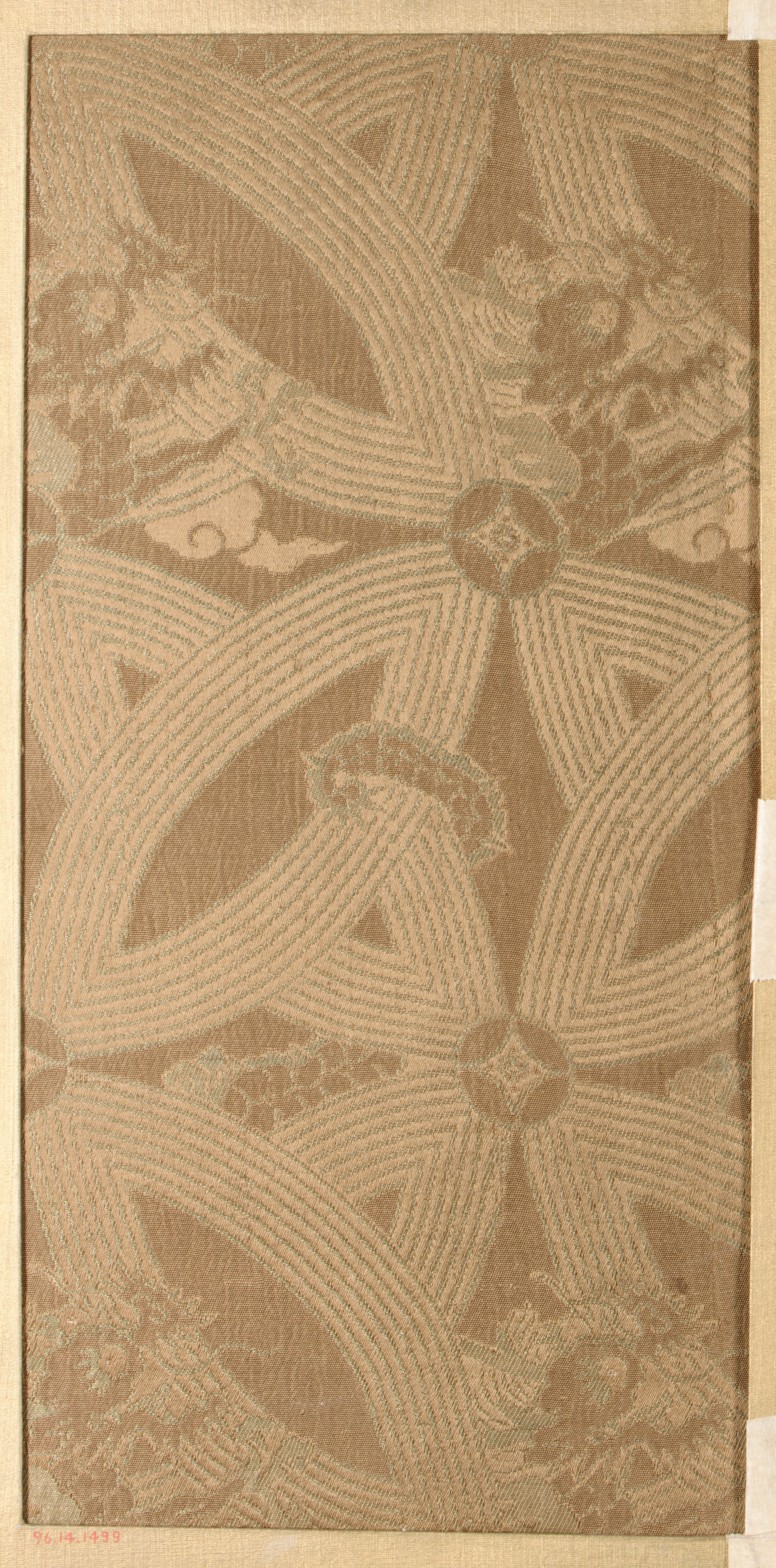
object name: piece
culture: japanese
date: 1701-1900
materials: silk